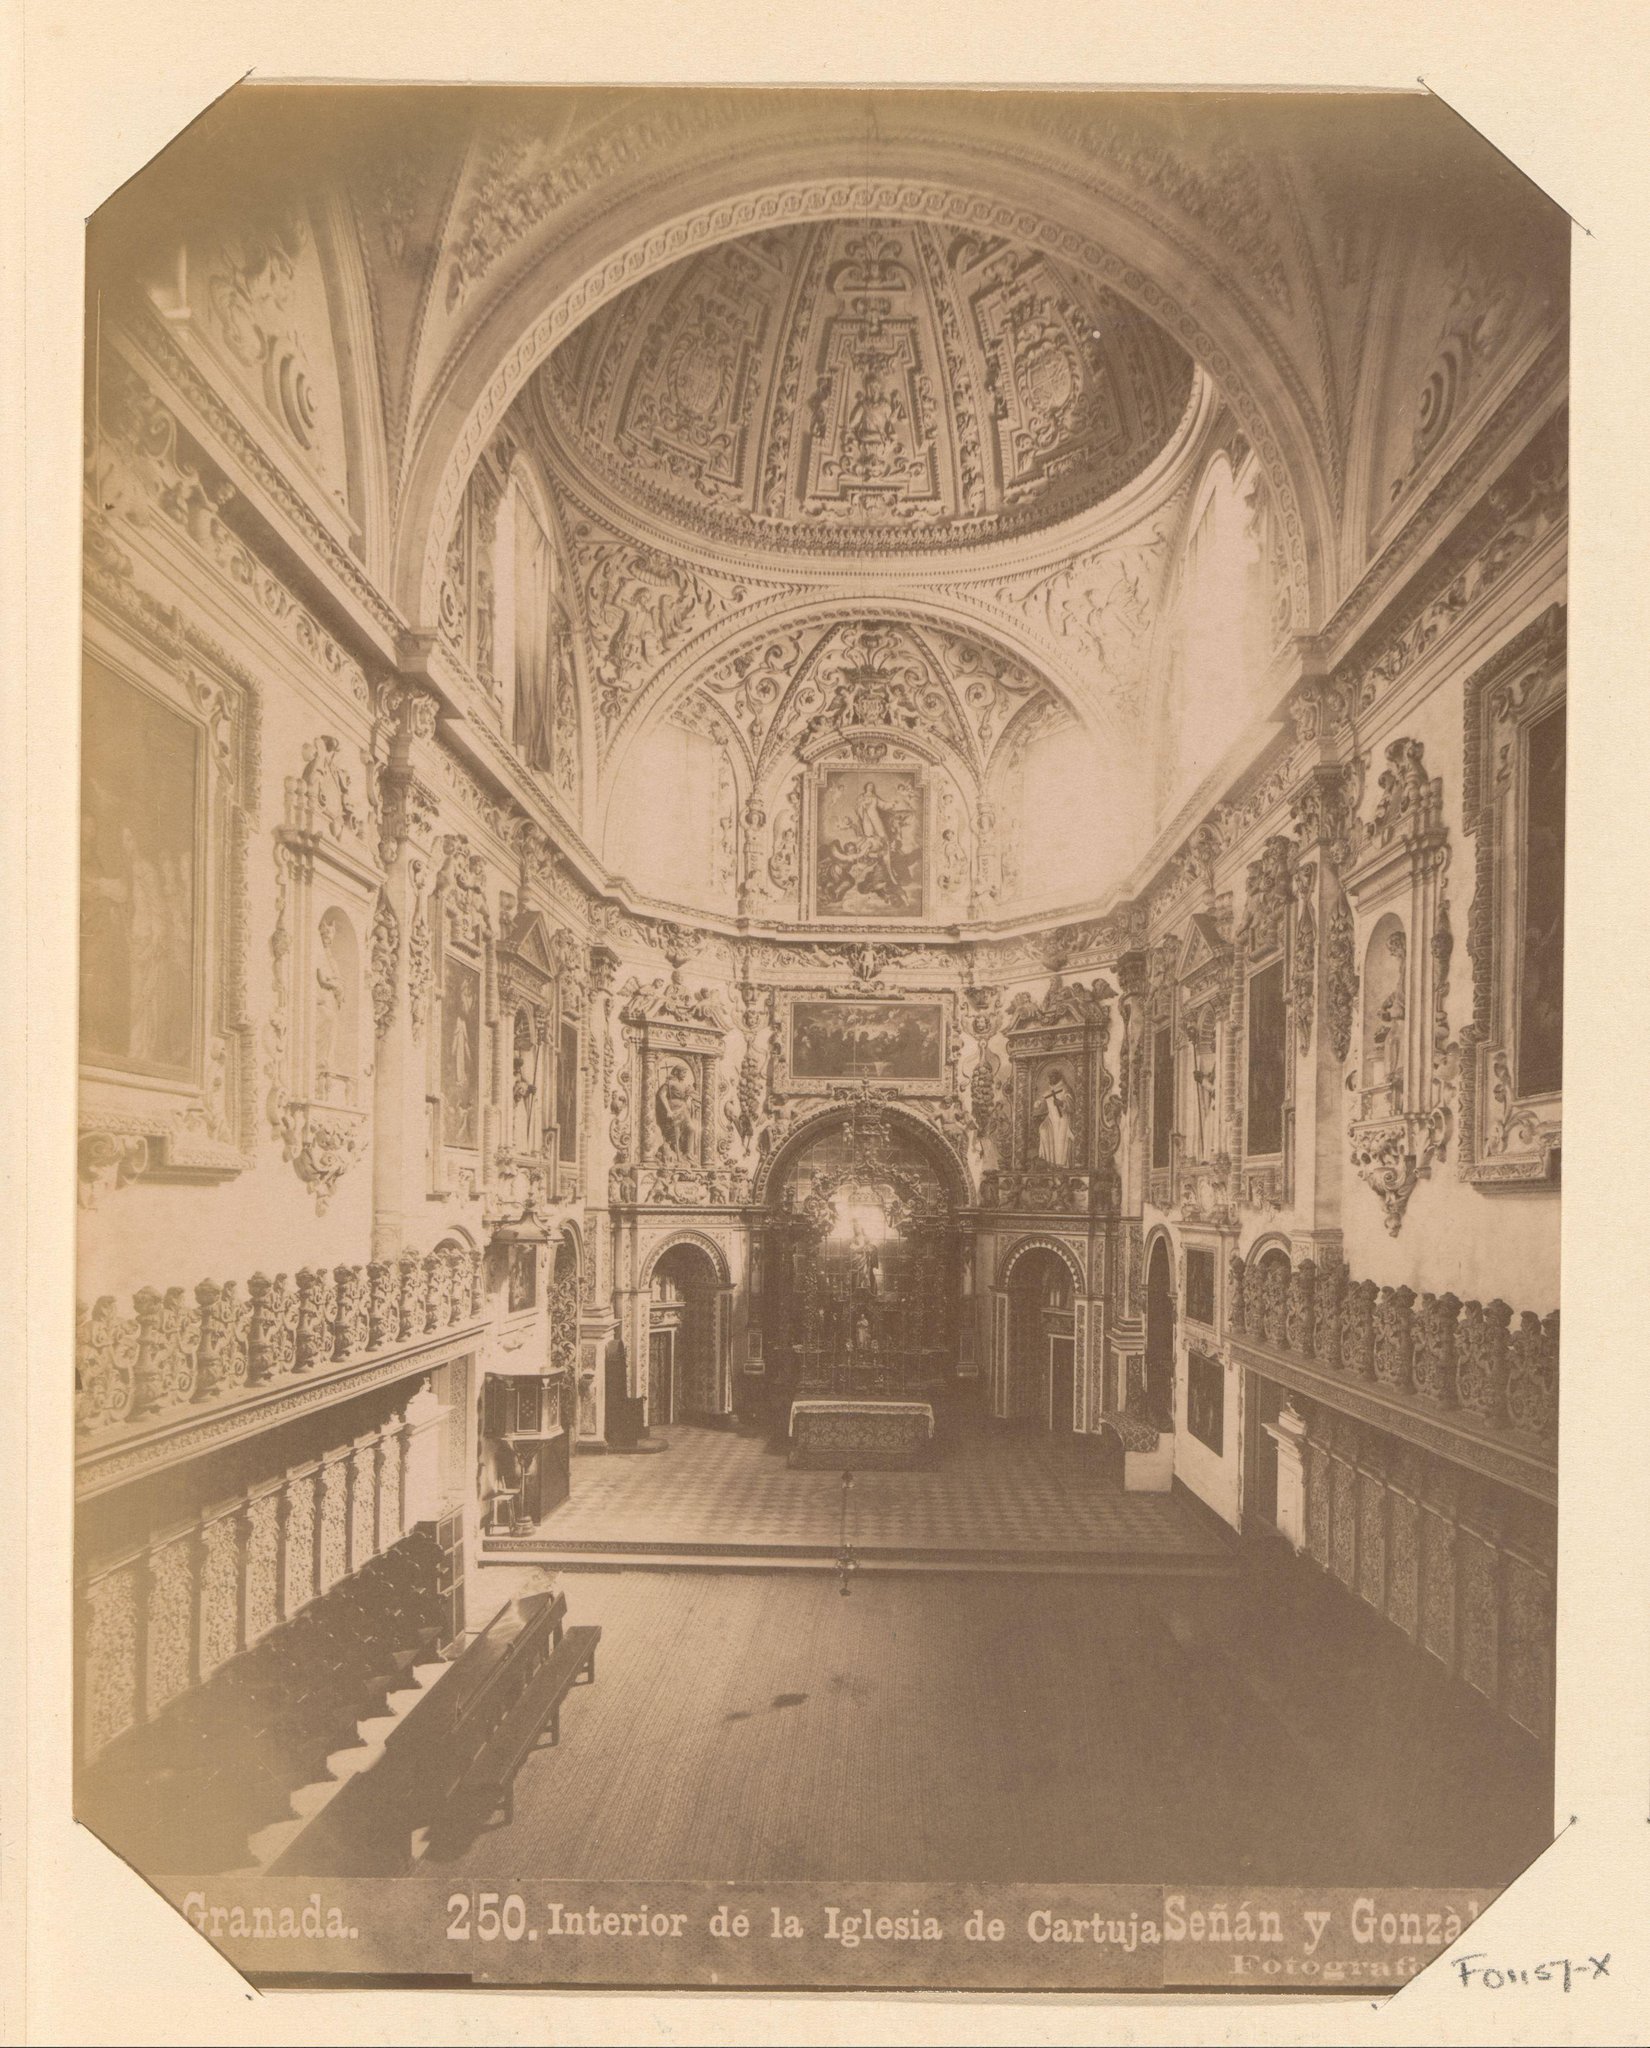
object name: album leaf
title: Granada - Interior de la Iglesia de Cartuja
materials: photographic support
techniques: albumen print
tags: interior of church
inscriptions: annotation: ‘Granada - Cartuja’, number: ‘250.’